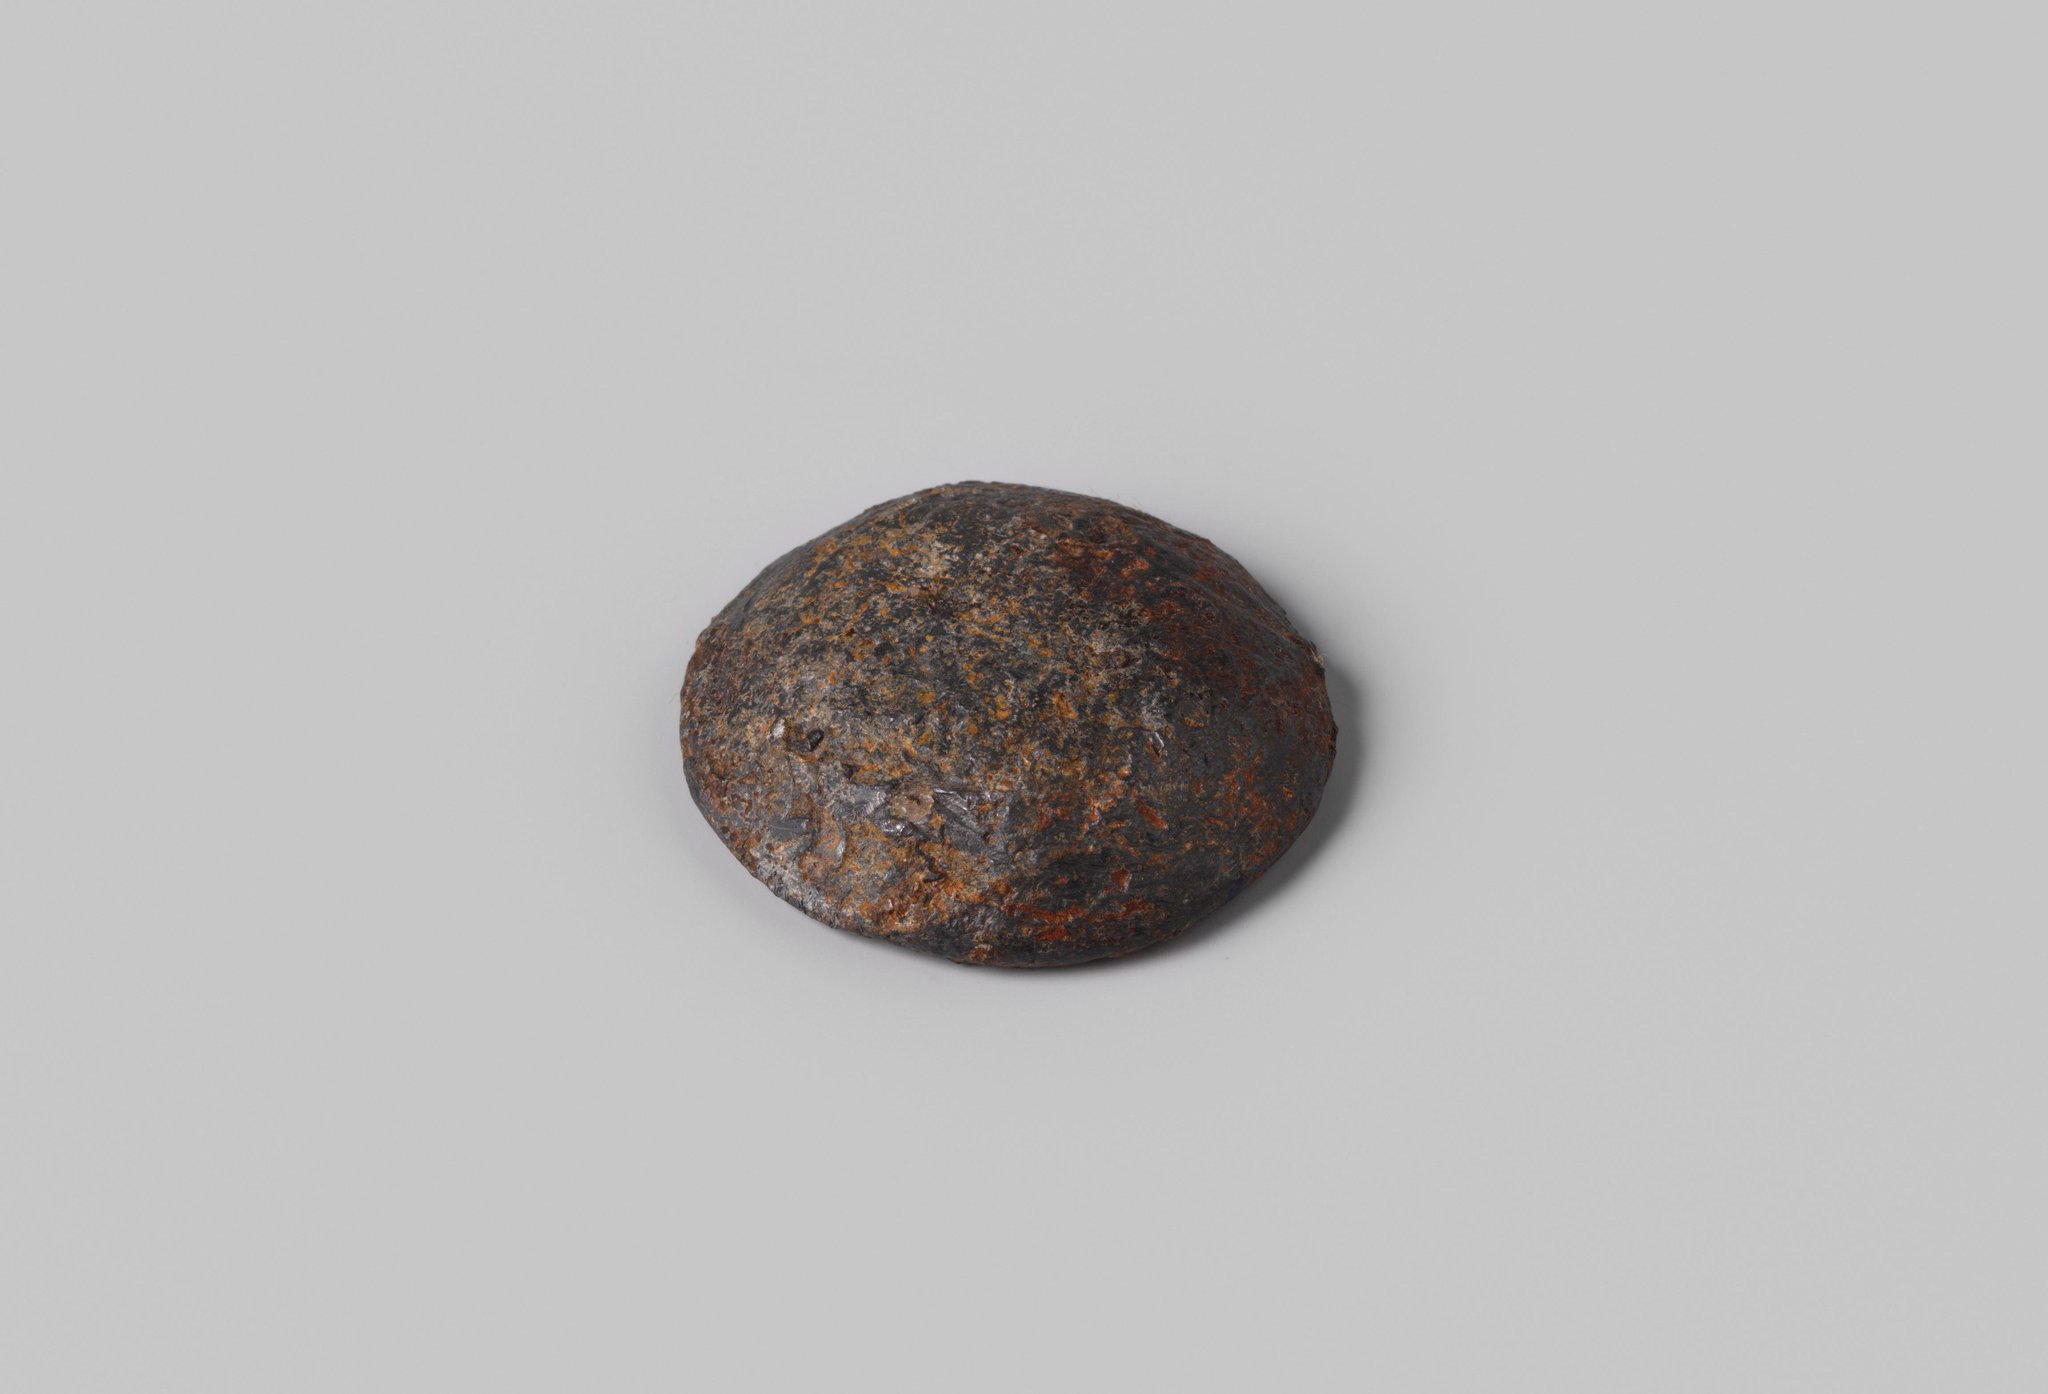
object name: weight scale component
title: Gewicht uit het wrak van de Oost-Indiëvaarder Hollandia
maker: Anonymous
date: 1700-1743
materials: lead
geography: netherlands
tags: verenigde oostindische compagnie, hollandia (schip), annet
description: Disc-shaped weight, sim. NG 1980-27H2928, eroded.